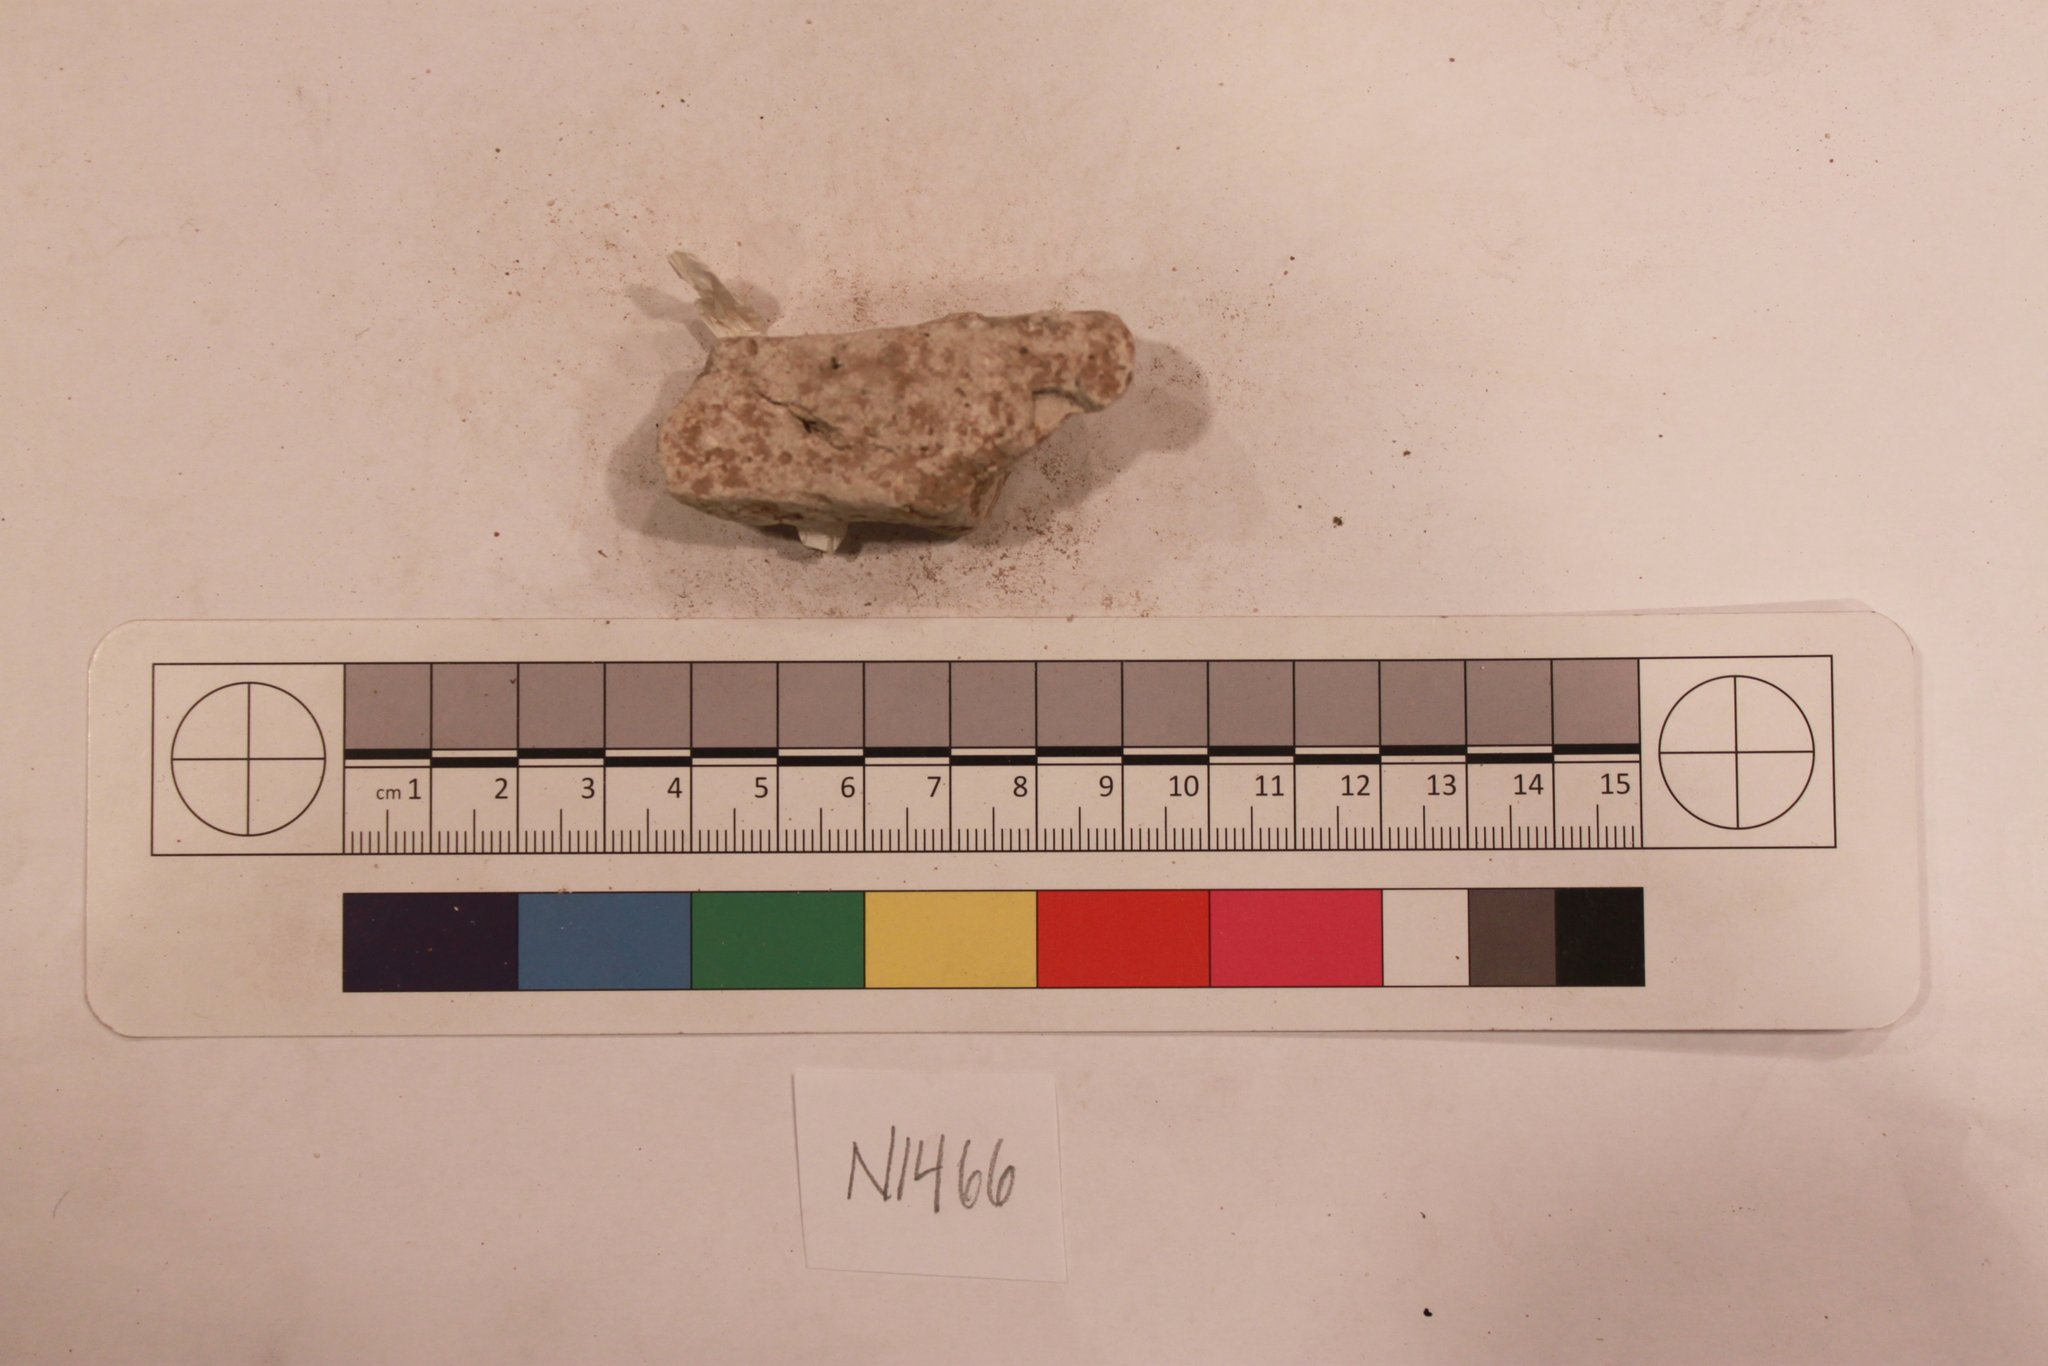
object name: fragment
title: Stucco Fragment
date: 701-1200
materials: plaster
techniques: carving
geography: iran